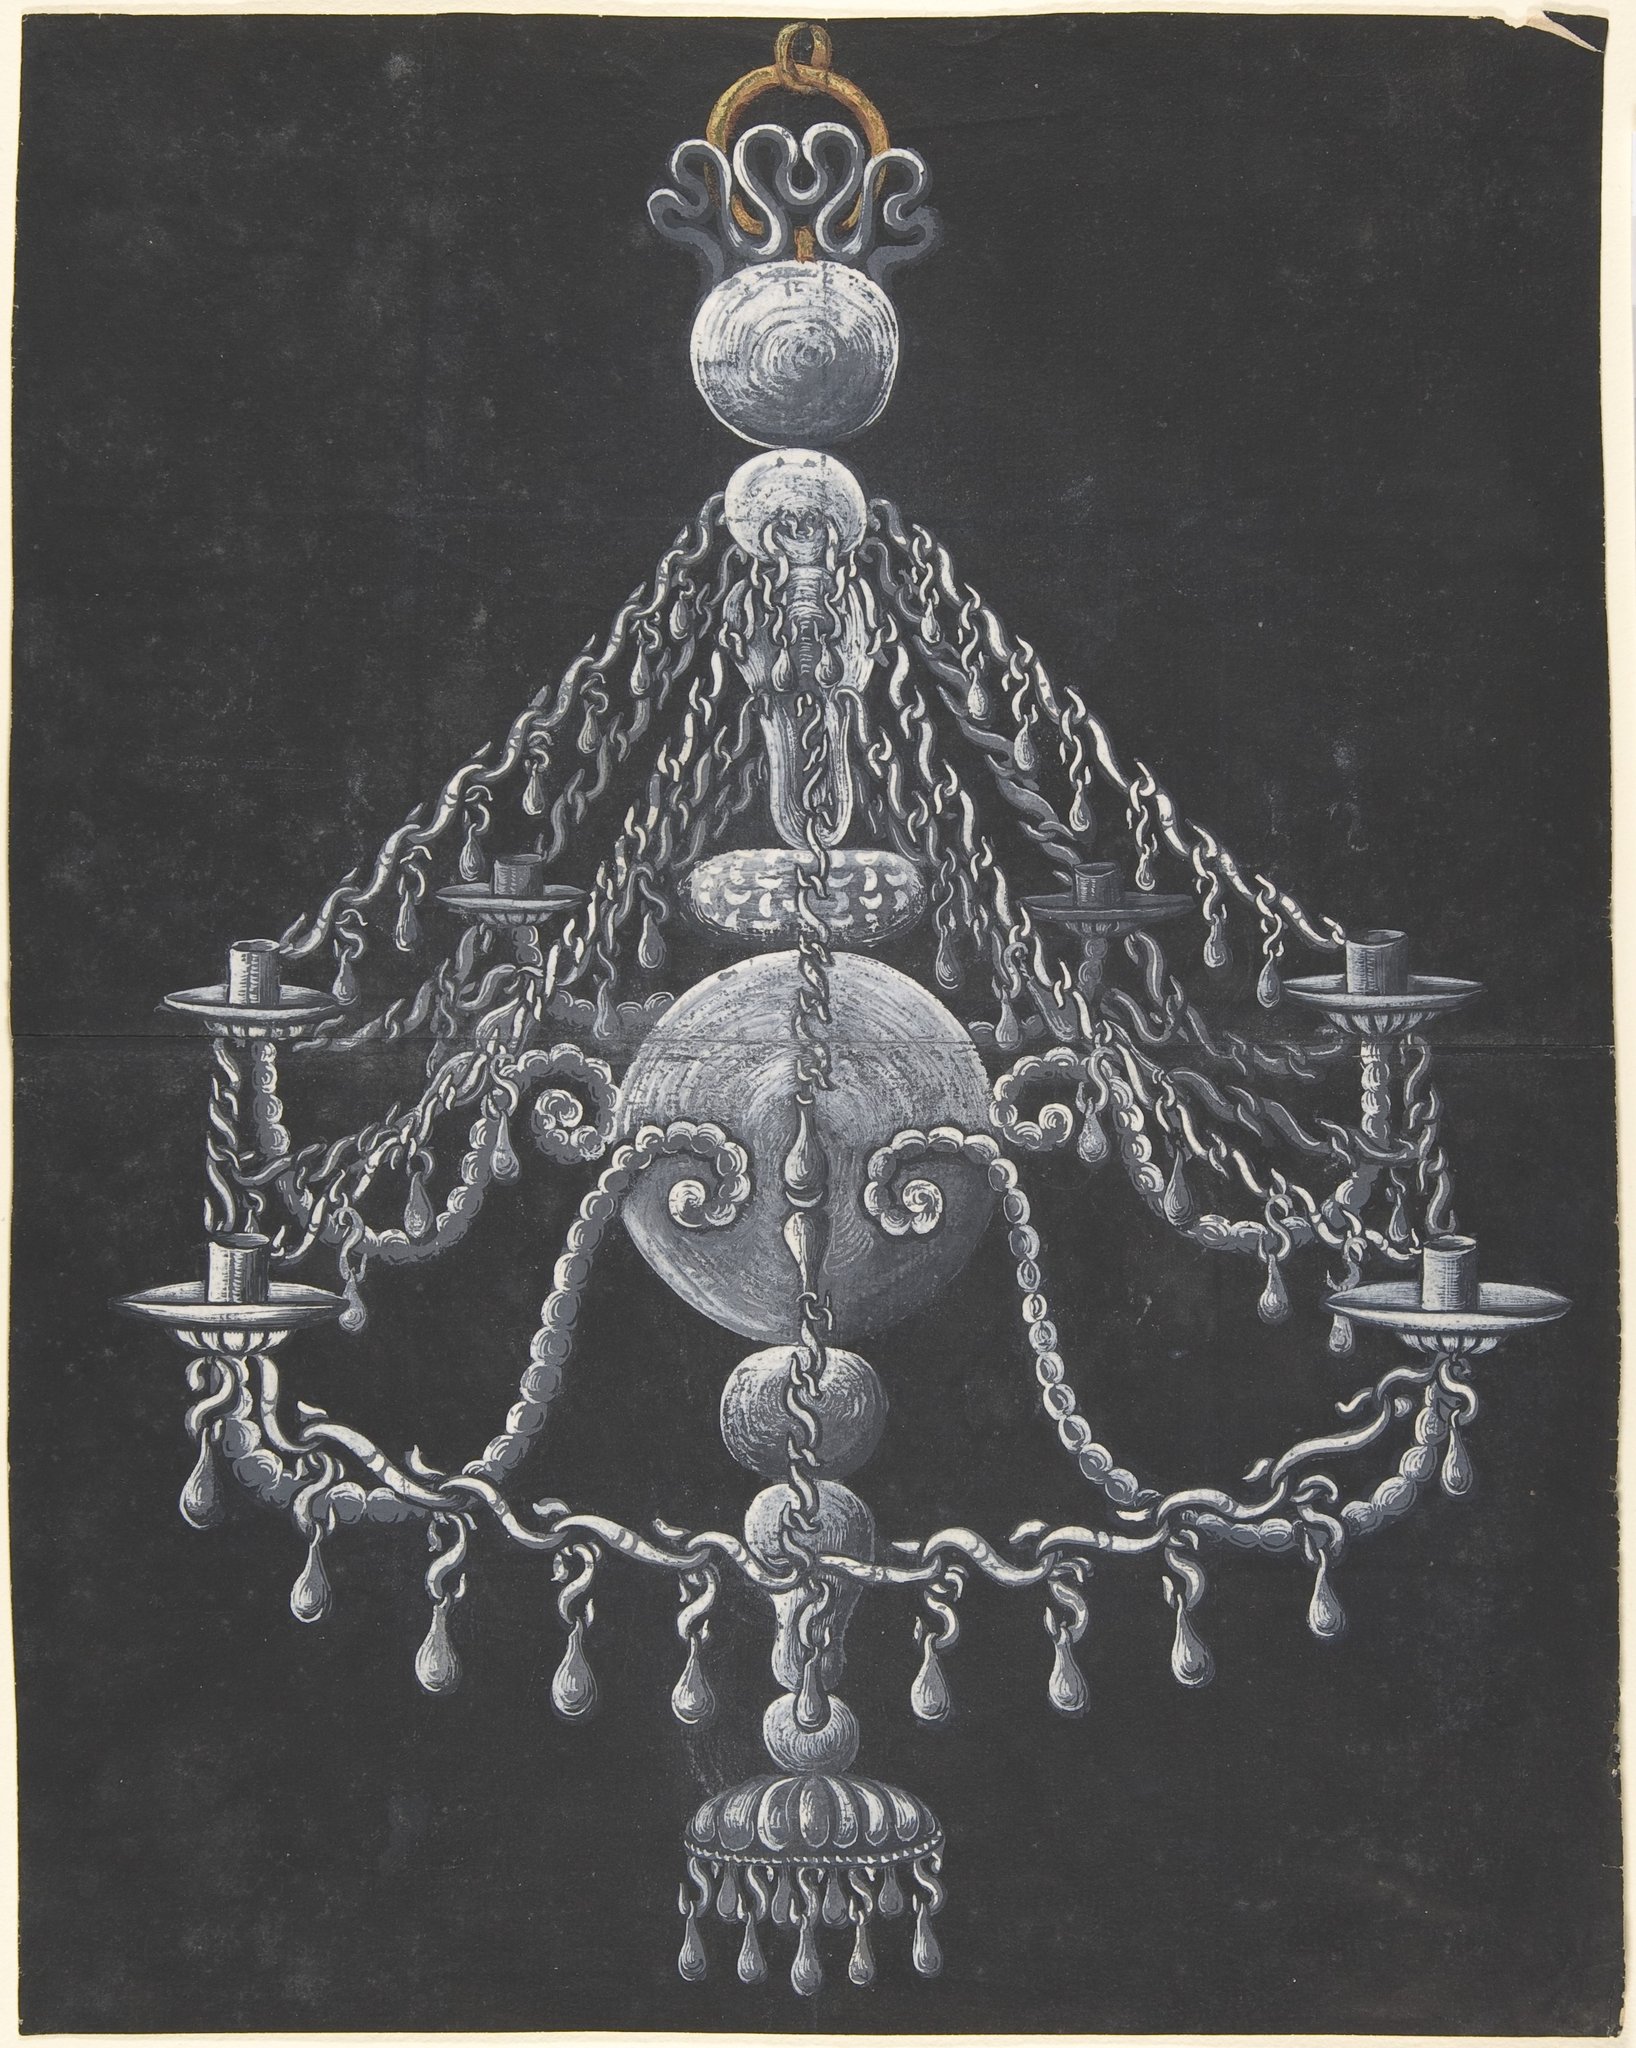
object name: drawing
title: Design for a Chandelier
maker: anonymous, german, 18th century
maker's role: artist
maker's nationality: german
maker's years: 1700-1800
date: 1701-1800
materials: gouache, paper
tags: chandelier